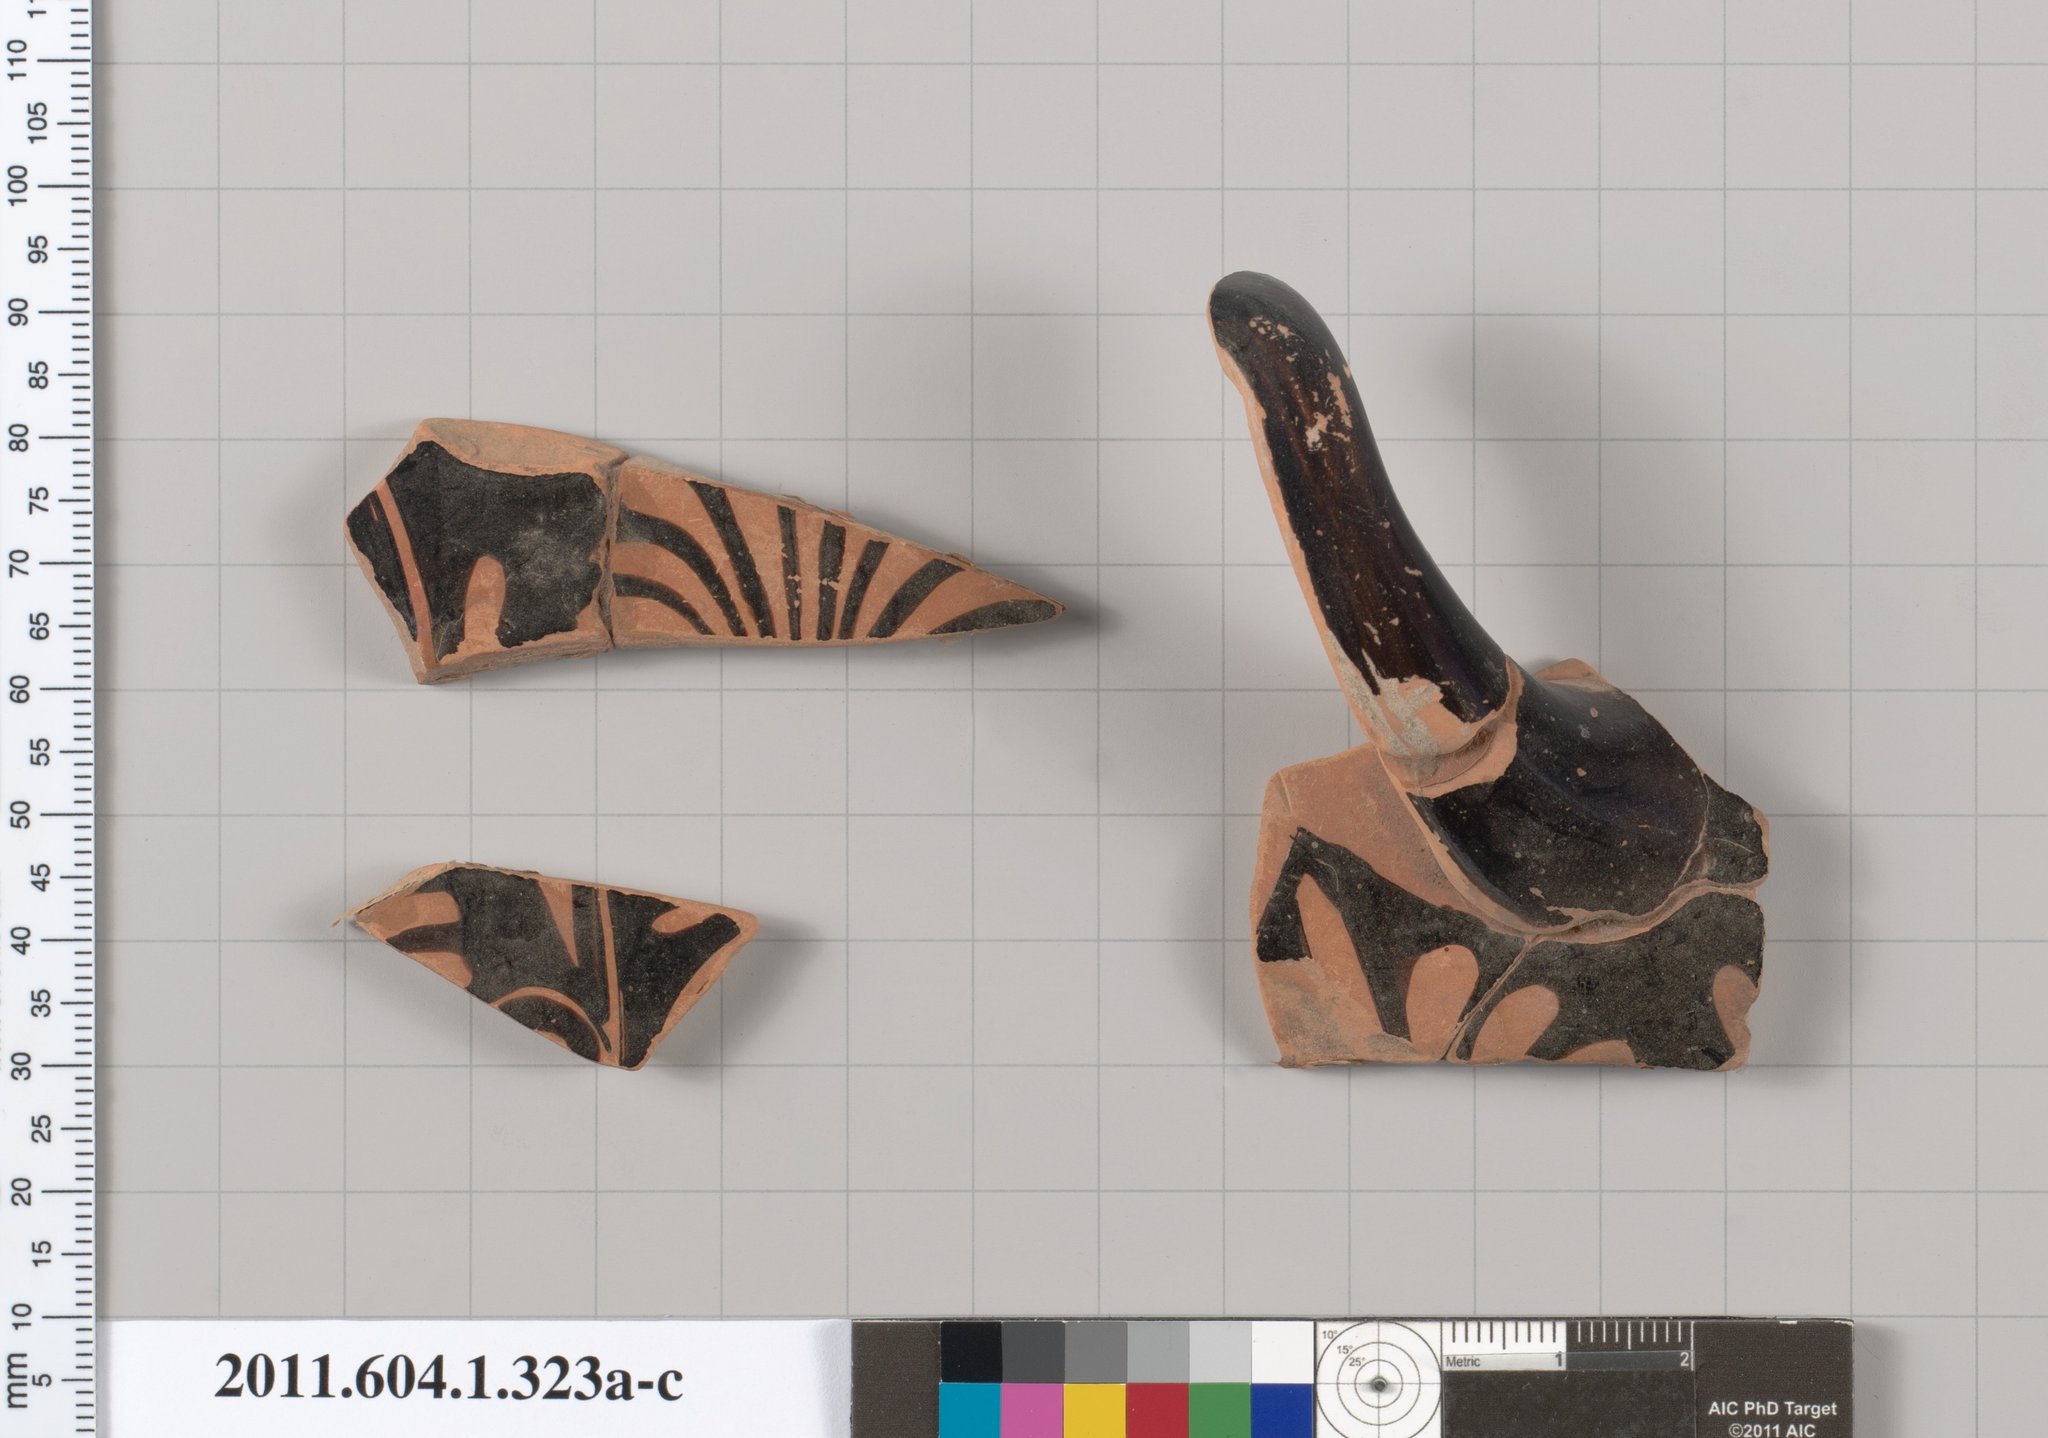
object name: kylix fragment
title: Terracotta fragments of a kylix (drinking cup)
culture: greek, attic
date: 475-451 BCE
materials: terracotta